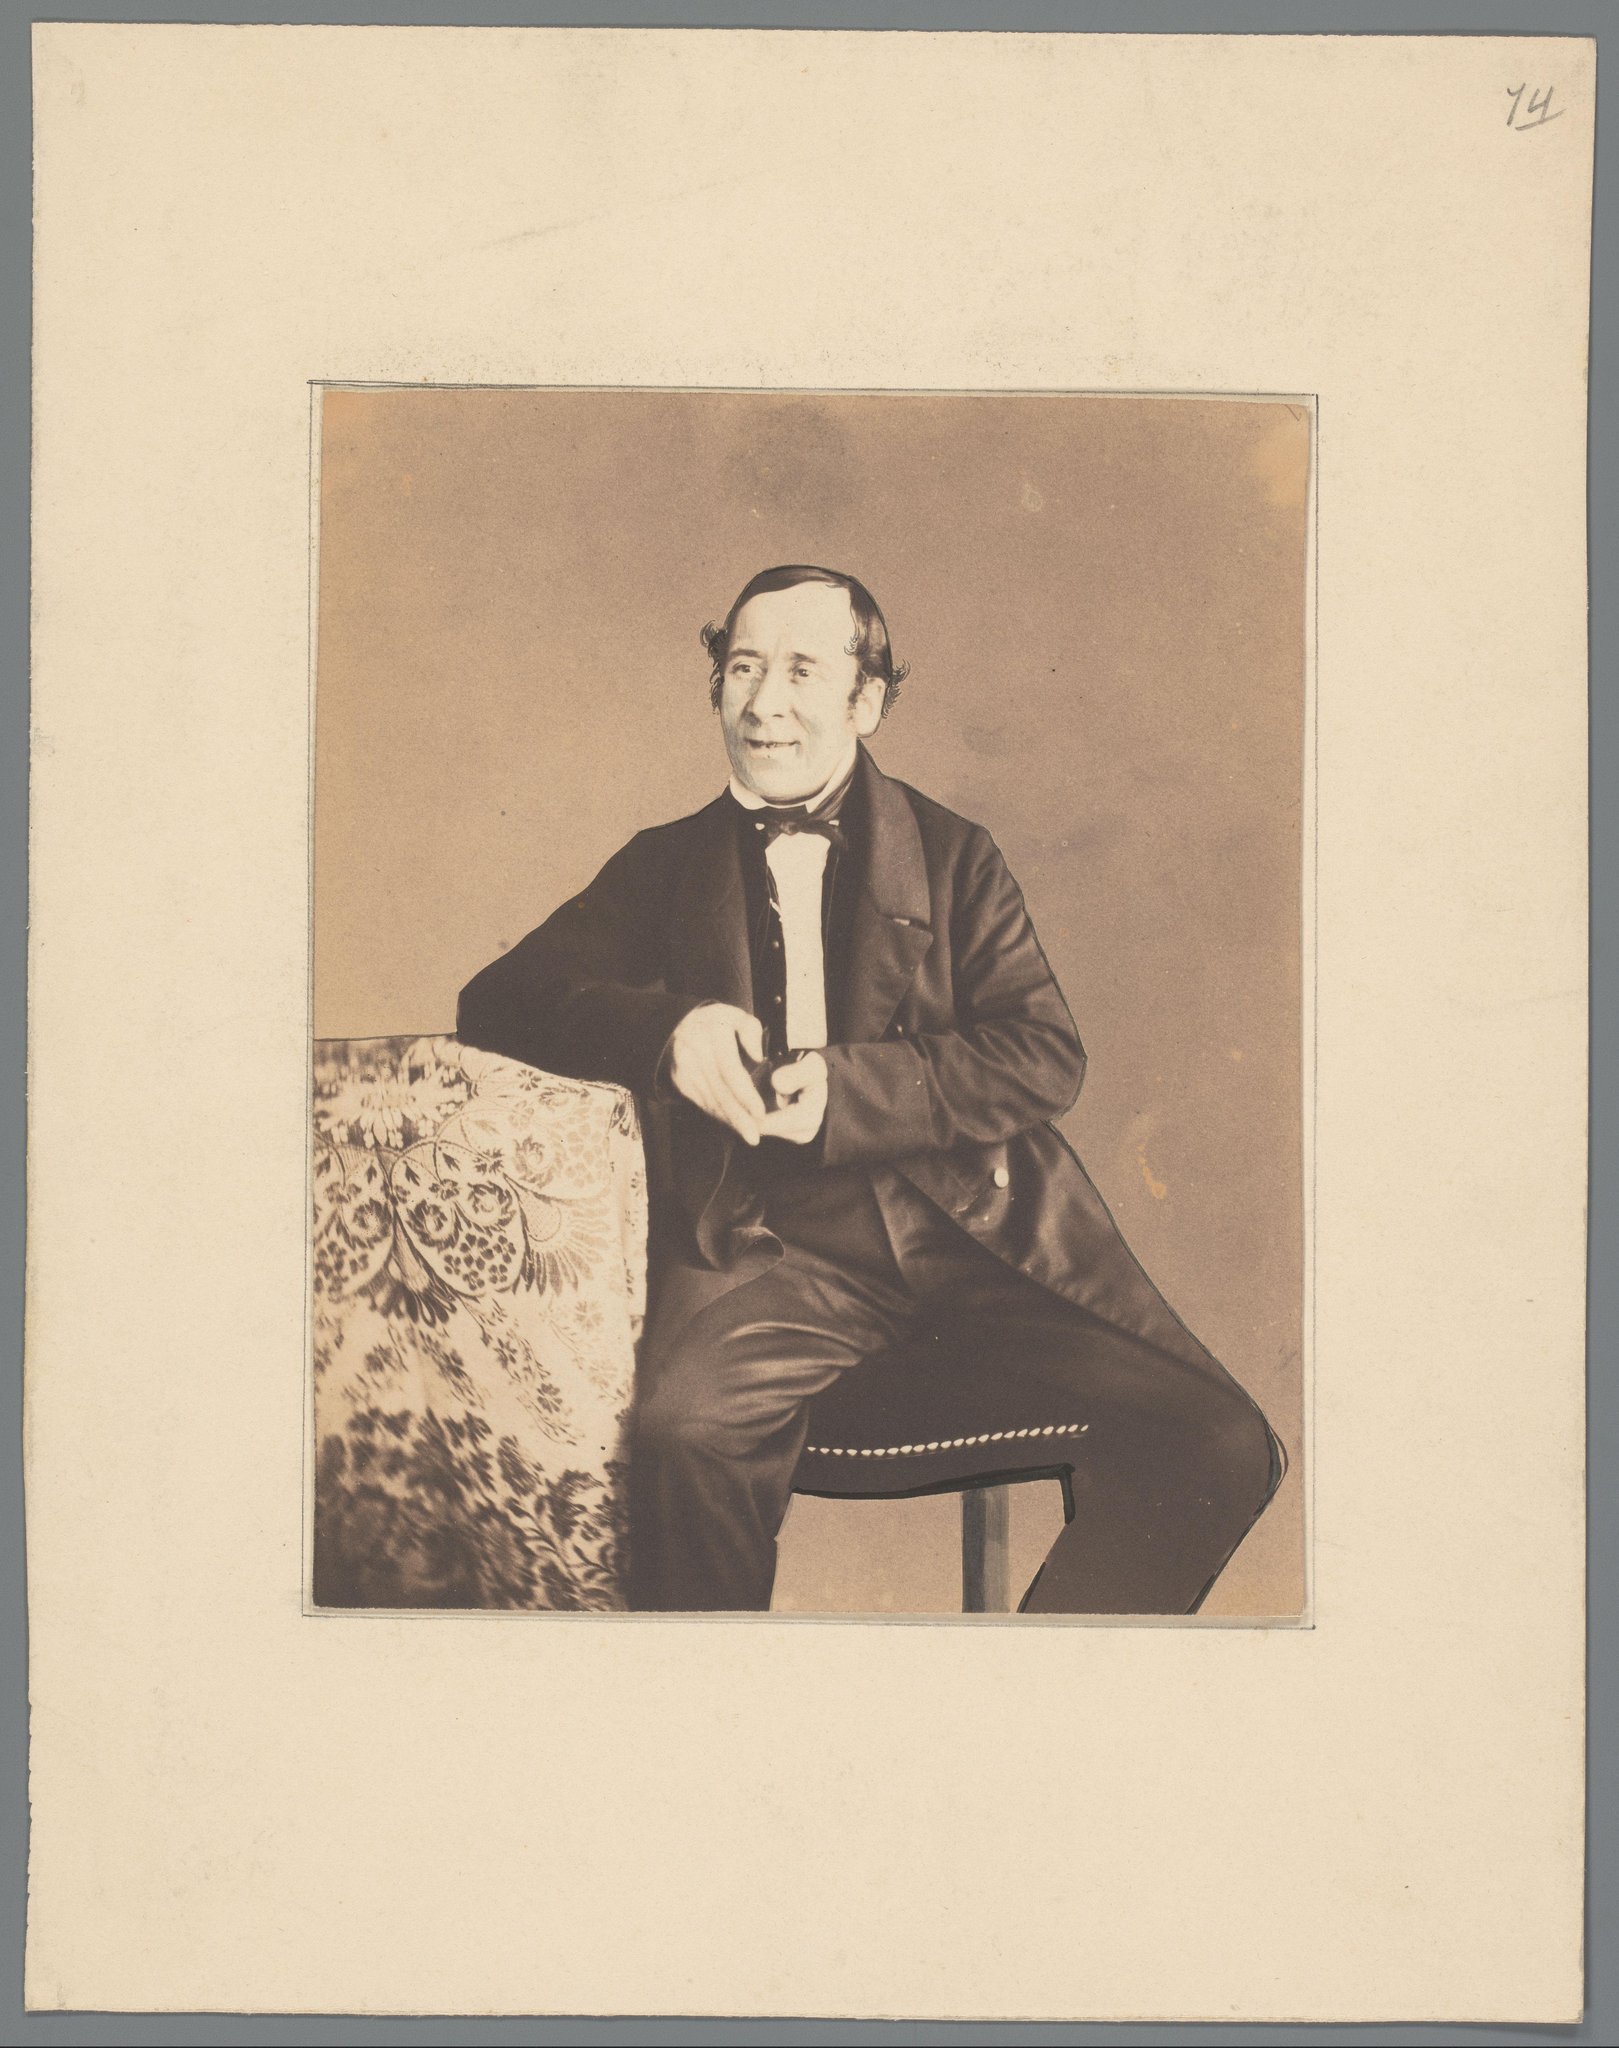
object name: photograph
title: Portret van een man, aangeduid als Th. Koorthals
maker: Anonymous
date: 1840-1860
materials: ink, paper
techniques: retouching, salted paper print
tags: historical persons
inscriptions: inscription: ‘Th. Koorthals’, number: ‘74’